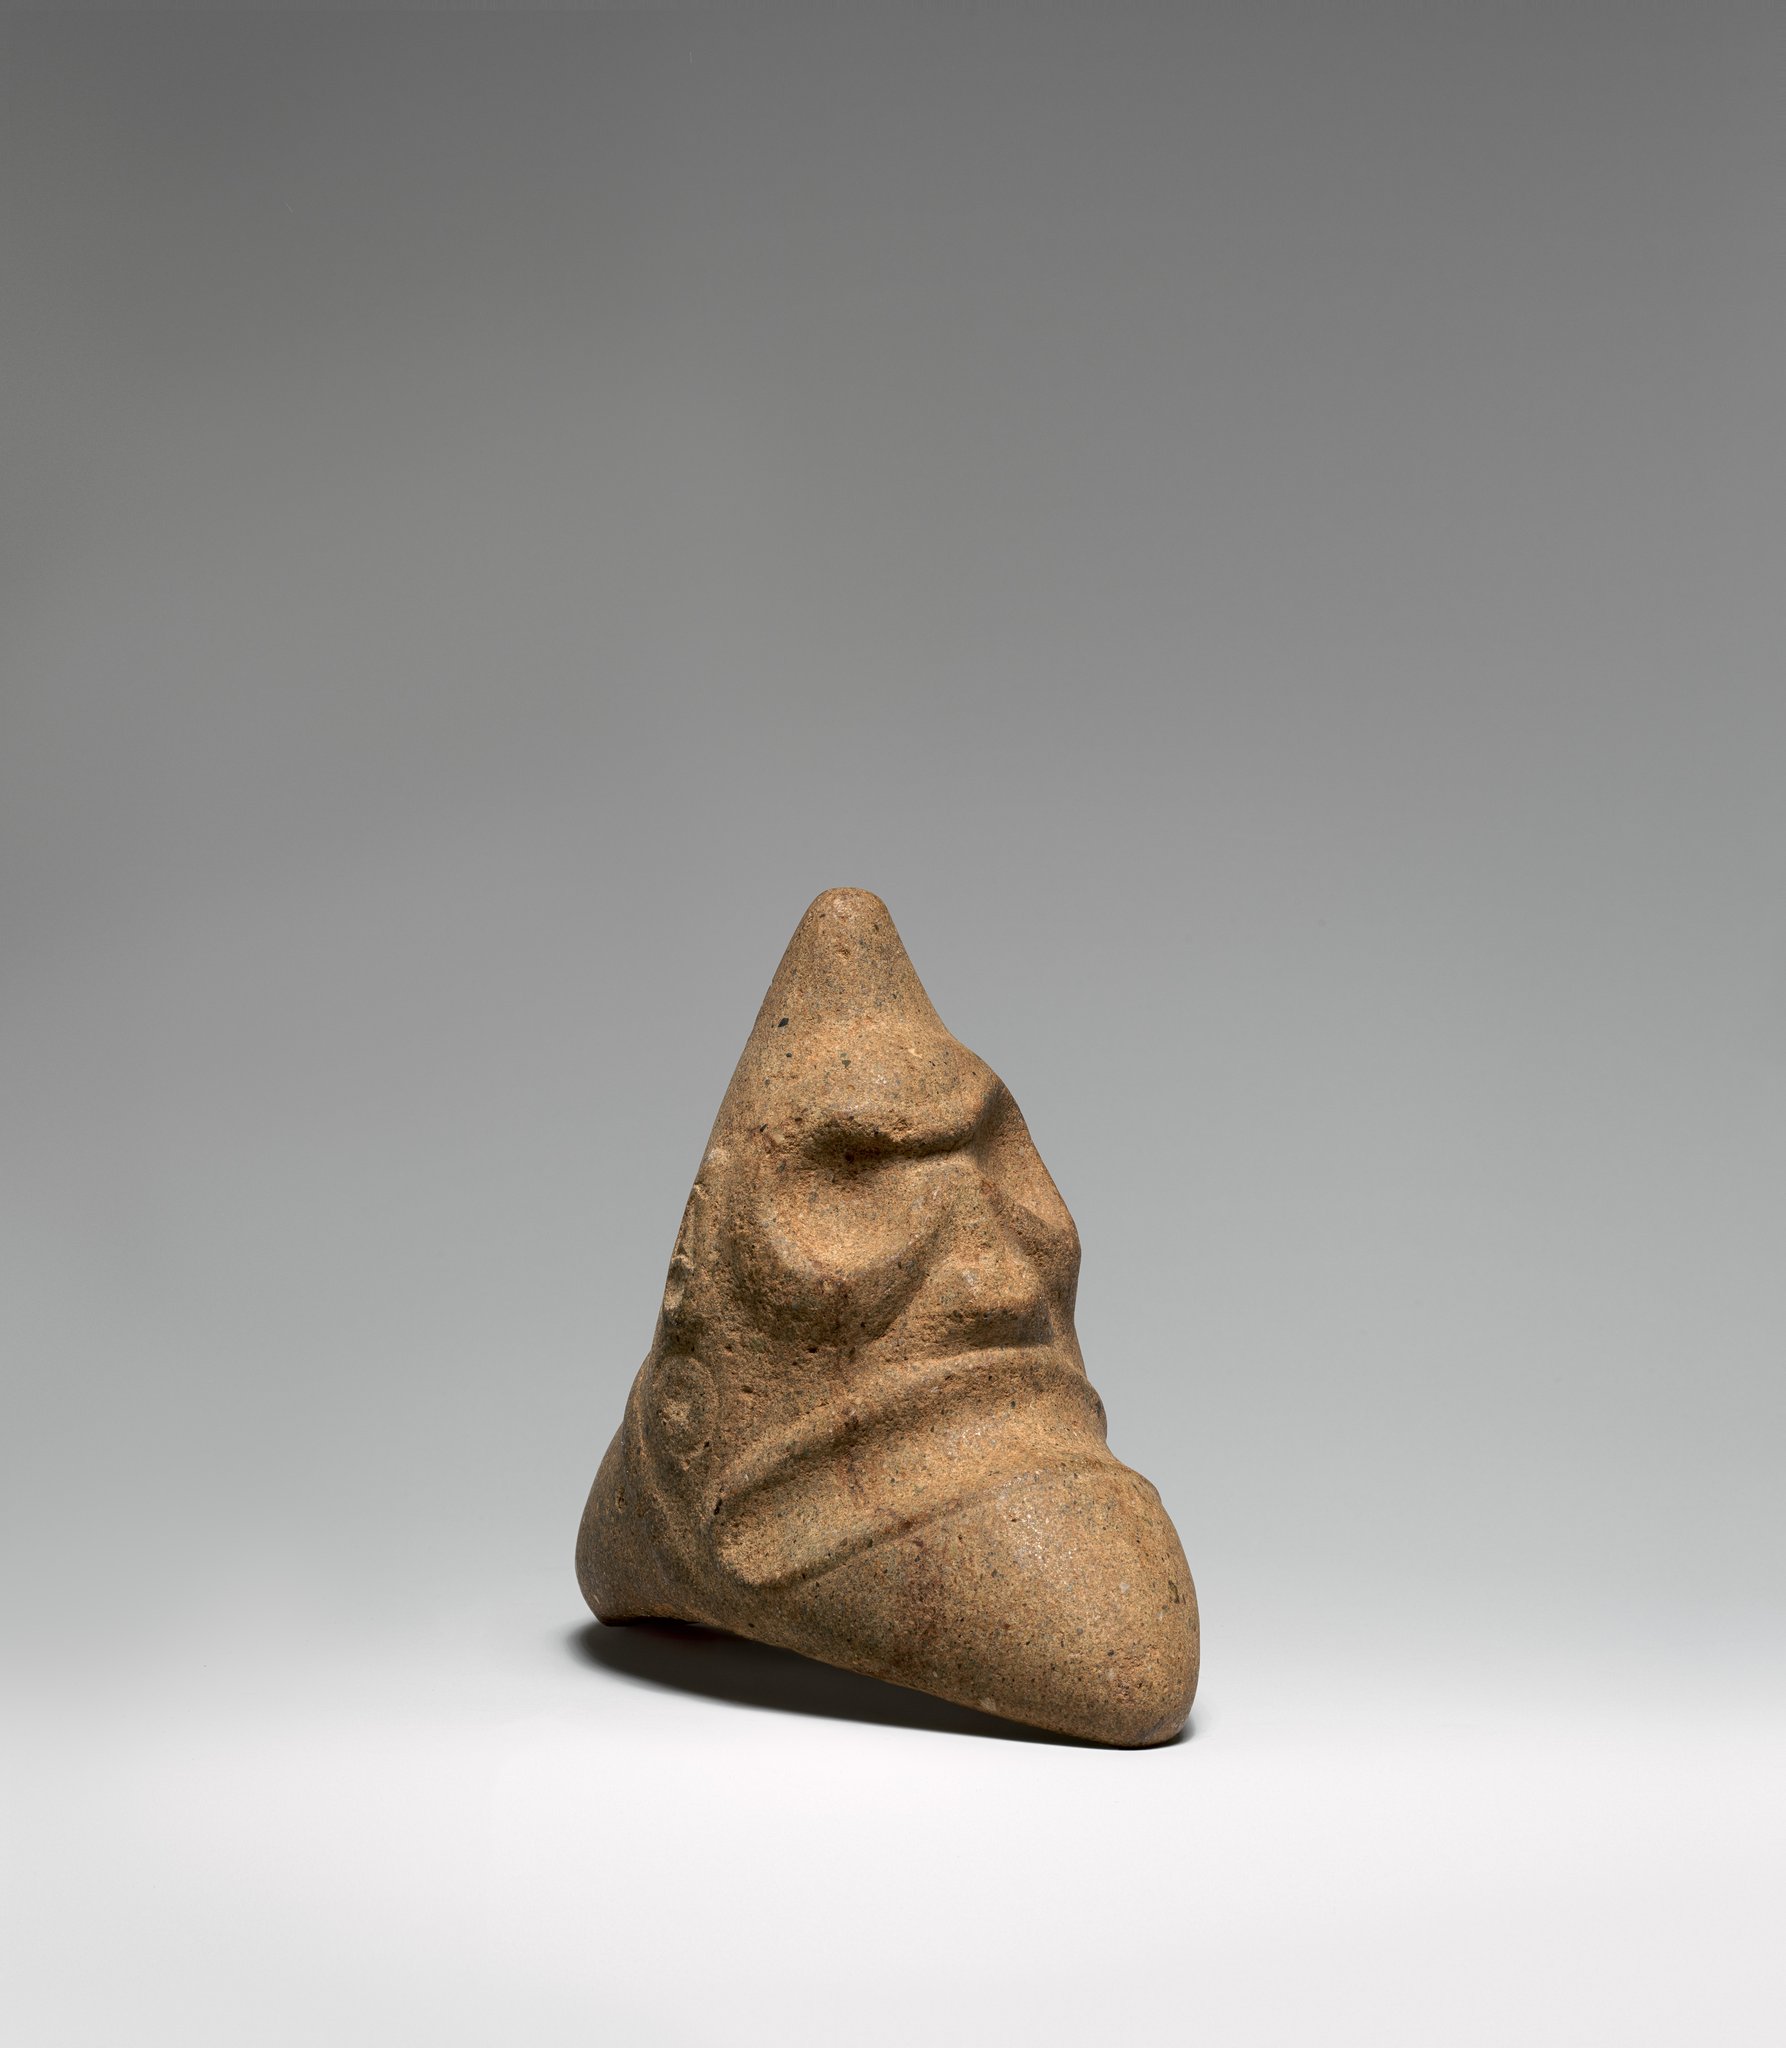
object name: stone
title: Three-Cornered Stone (Trigonolito) with Face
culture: taíno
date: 1201-1500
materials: stone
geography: dominican republic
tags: faces